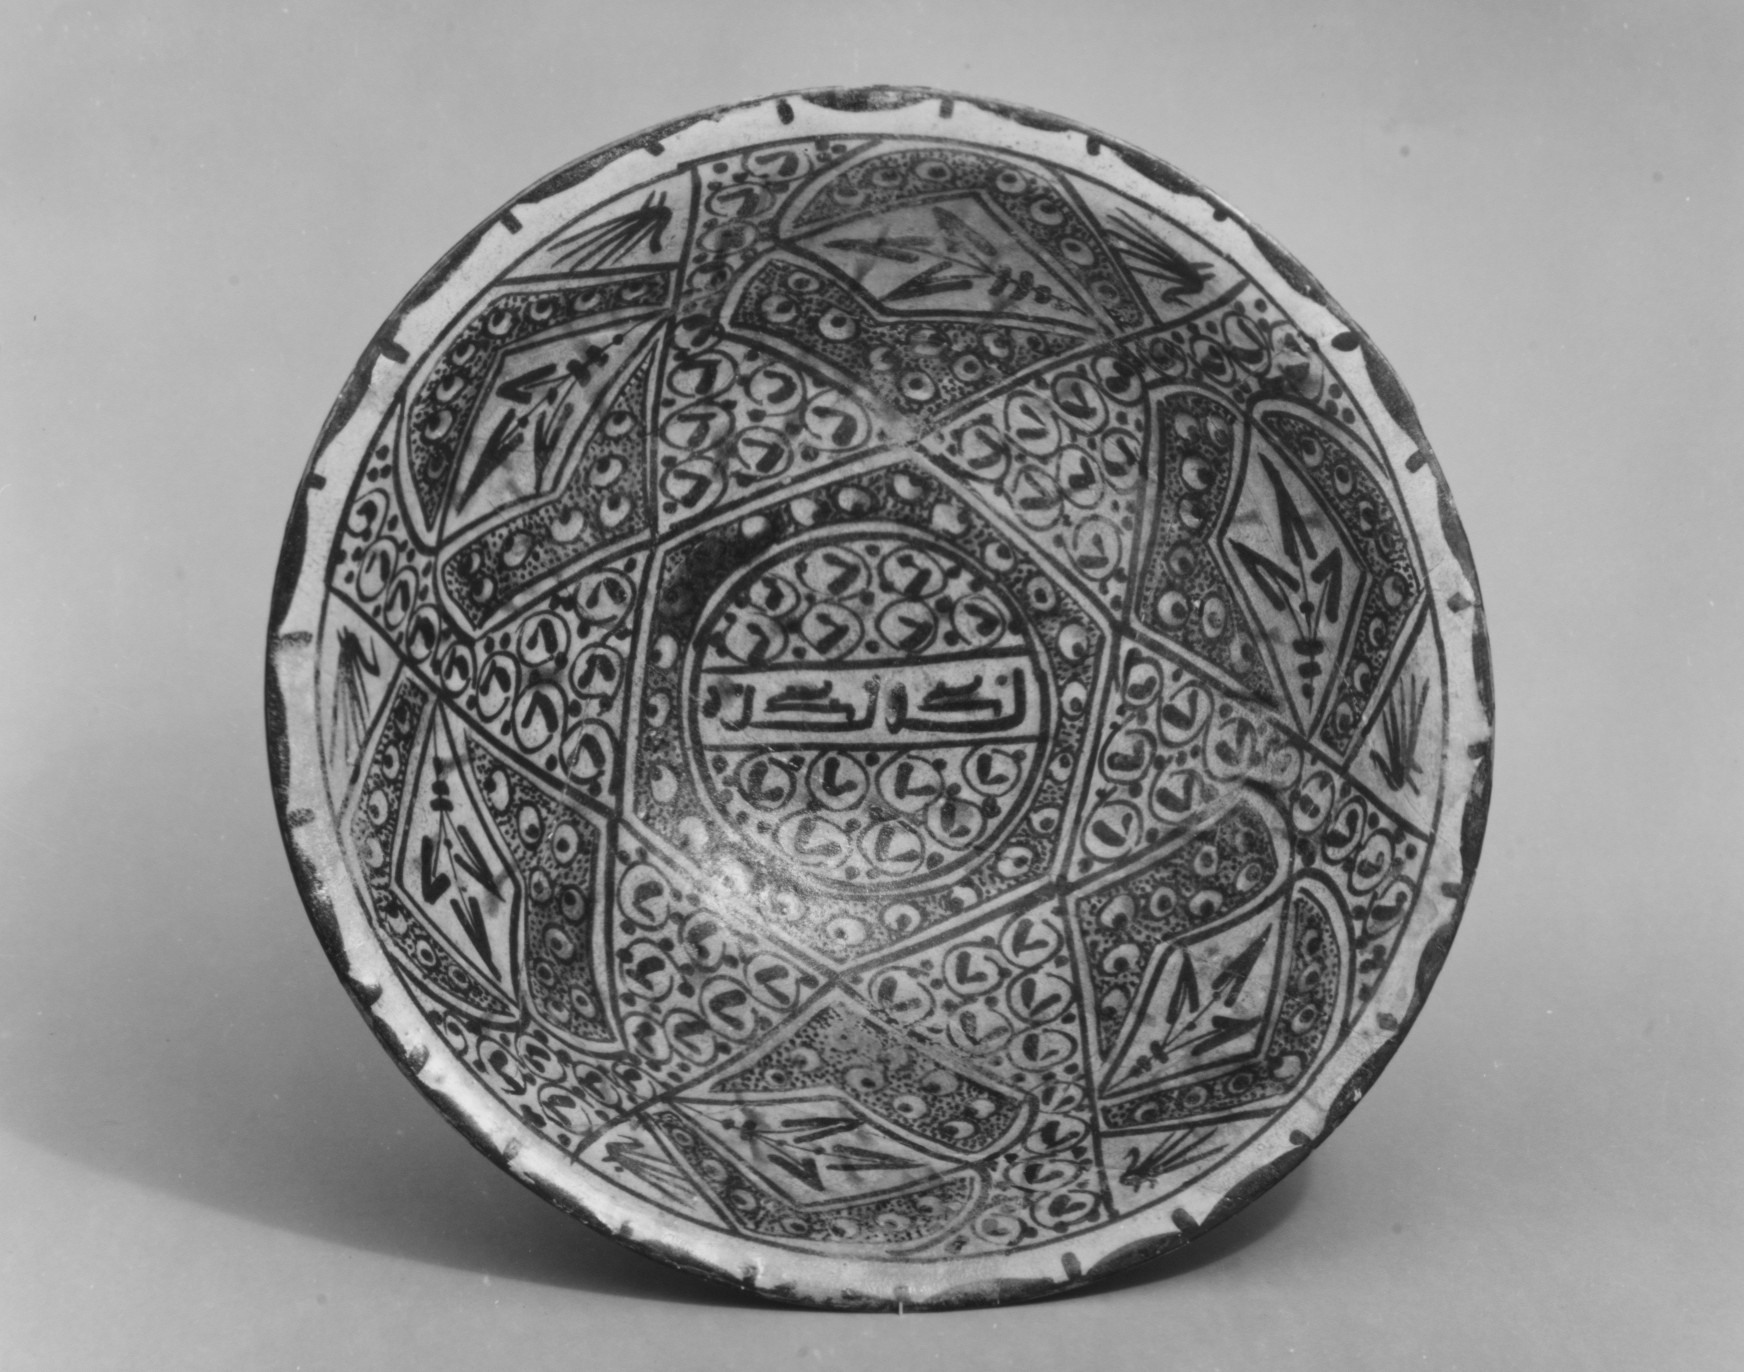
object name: bowl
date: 801-1000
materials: earthenware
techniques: glazing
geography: iran